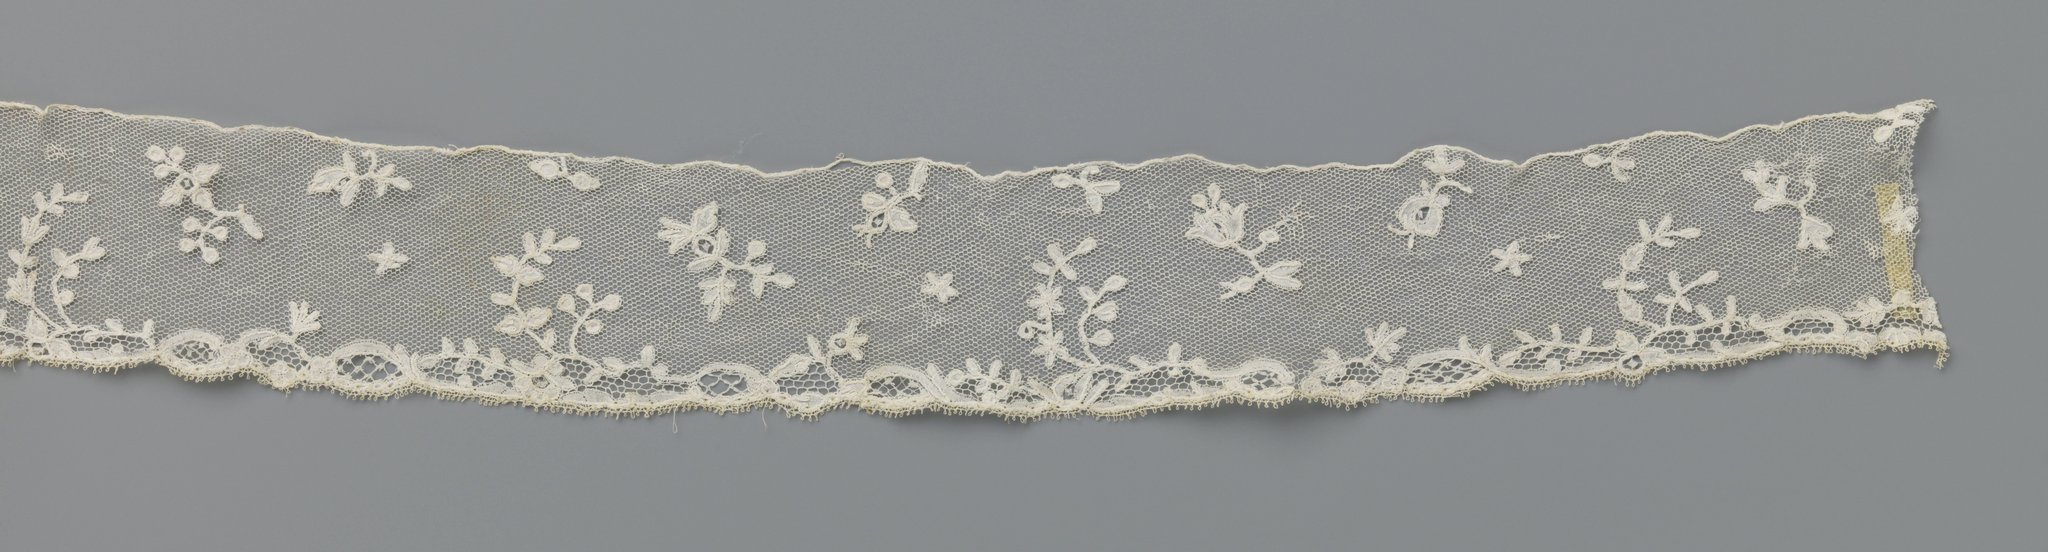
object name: strip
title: Strook kloskant met gestrooide takjes en gebogen dubbele takjes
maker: Anonymous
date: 1775-1795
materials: linen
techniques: lace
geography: brussels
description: Strook naturelkleurige Brusselse kloskant. Het patroon bestaat uit gestrooide bloempjes aan stelen, sterretjes en takjes met bessen. Langs de onderzijde loopt een rand met verschillende aaneengeschakelde ovaaltjes, waaruit dubbele takjes ontspringen die links van het midden van de strook naar links buigen en rechts van het midden naar rechts buigen. De motieven zijn met elkaar verbonden door een fijne maasgrond, een drochelgrond. De motieven zijn gemaakt in linnenslag met opengewerkte randjes en grotendeels voorzien van gekloste reliëfcontouren. In de bloemharten van de grotere gestrooide bloemen is een blokje gemaakt in vormslag. In de ovaaltjes langs de onderzijde zijn siergronden toegepast met grovere mazen dan de drochelgrond. De bovenzijde is recht afgewerkt. De flauw geschulpte onderzijde is afgewerkt met picots.